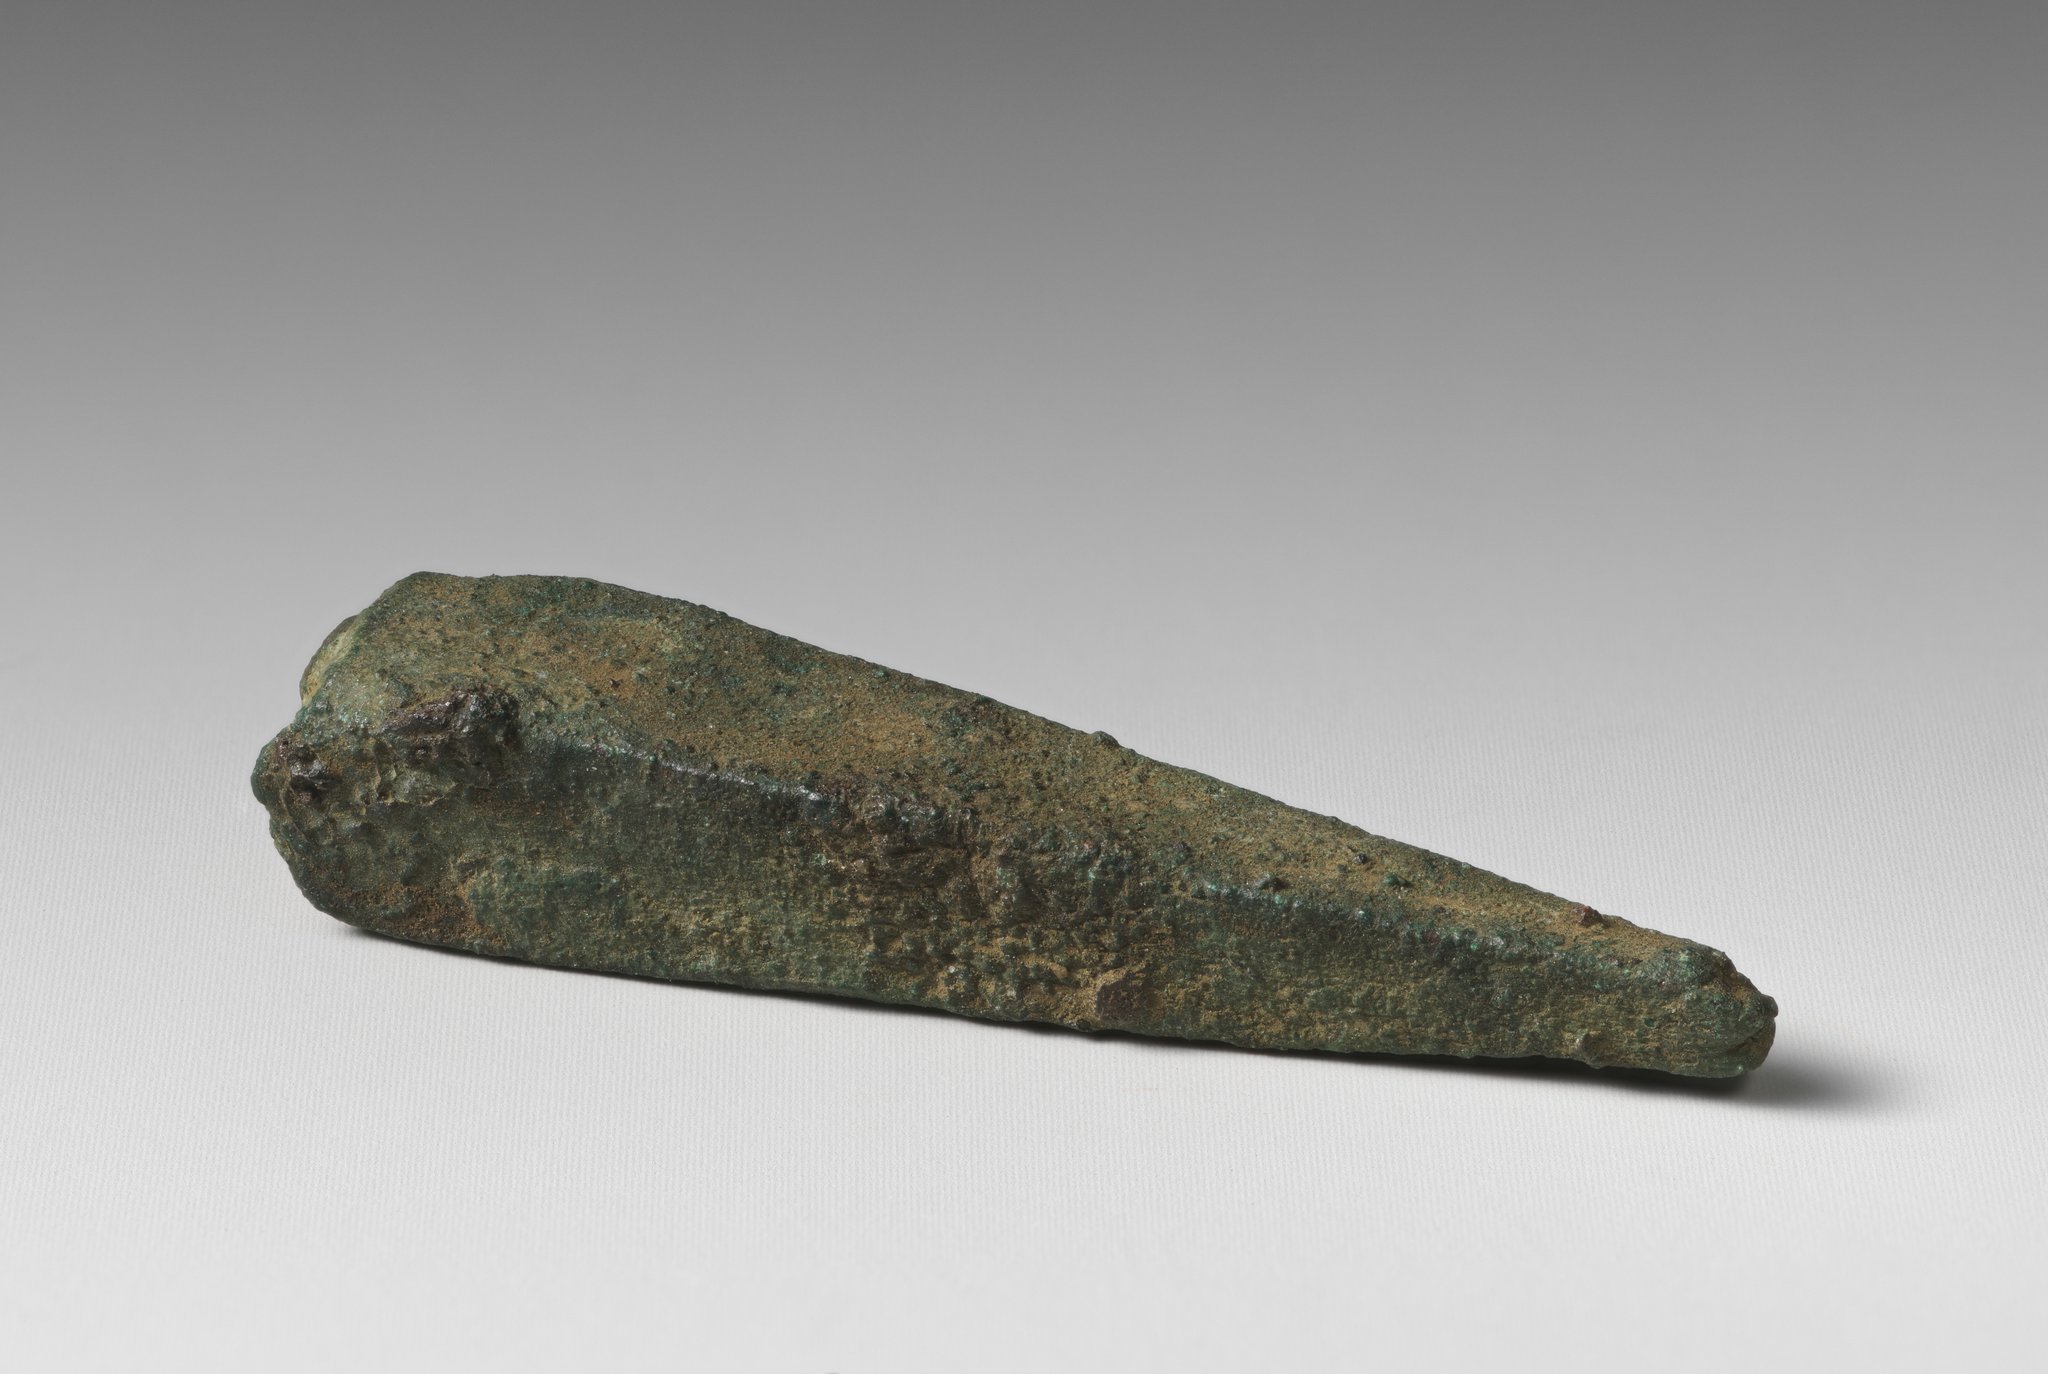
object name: nail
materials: bronze, copper alloy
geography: egypt